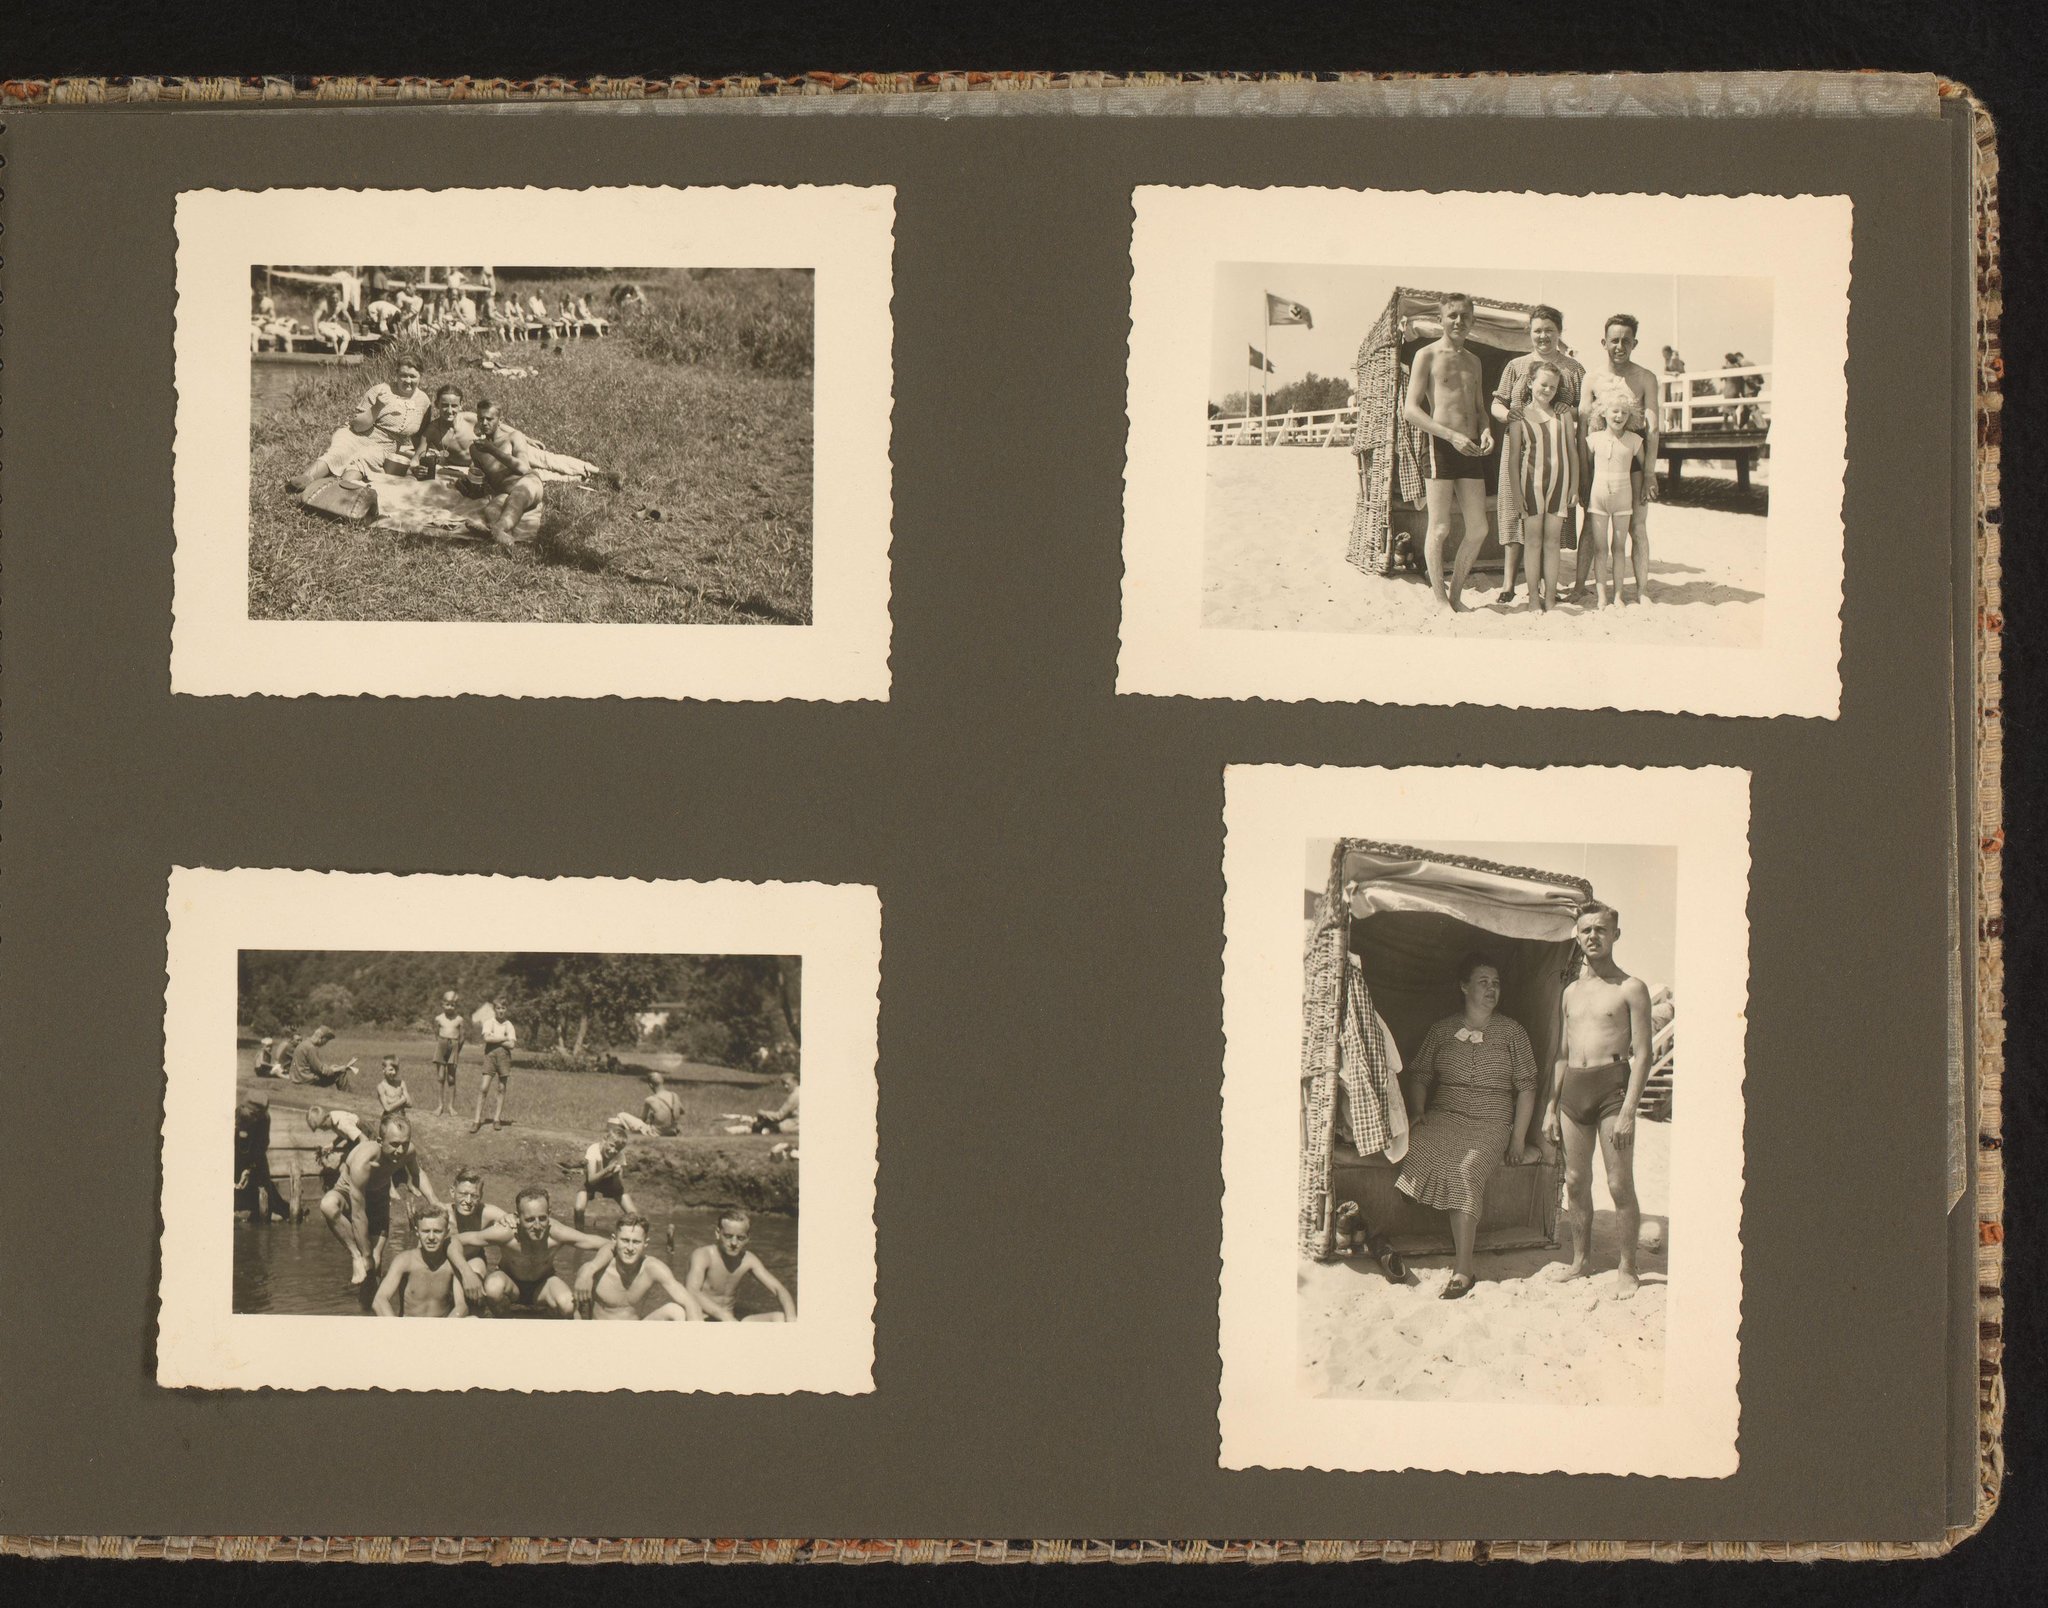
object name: photograph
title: Familie en vrienden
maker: Anonymous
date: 1935-1940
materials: cardboard, photographic support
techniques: gelatin silver print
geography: germany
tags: beach (as place of recreation), outing, pleasure trip, the soldier off duty, germany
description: Albumblad met vier foto's van vrije tijd met familie en vrienden aan het water en op het strand. Onderdeel van het fotoalbum Duitse bezetting van Nederland.